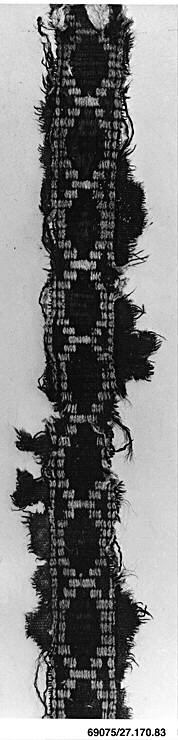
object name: strip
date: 701-800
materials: wool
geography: egypt